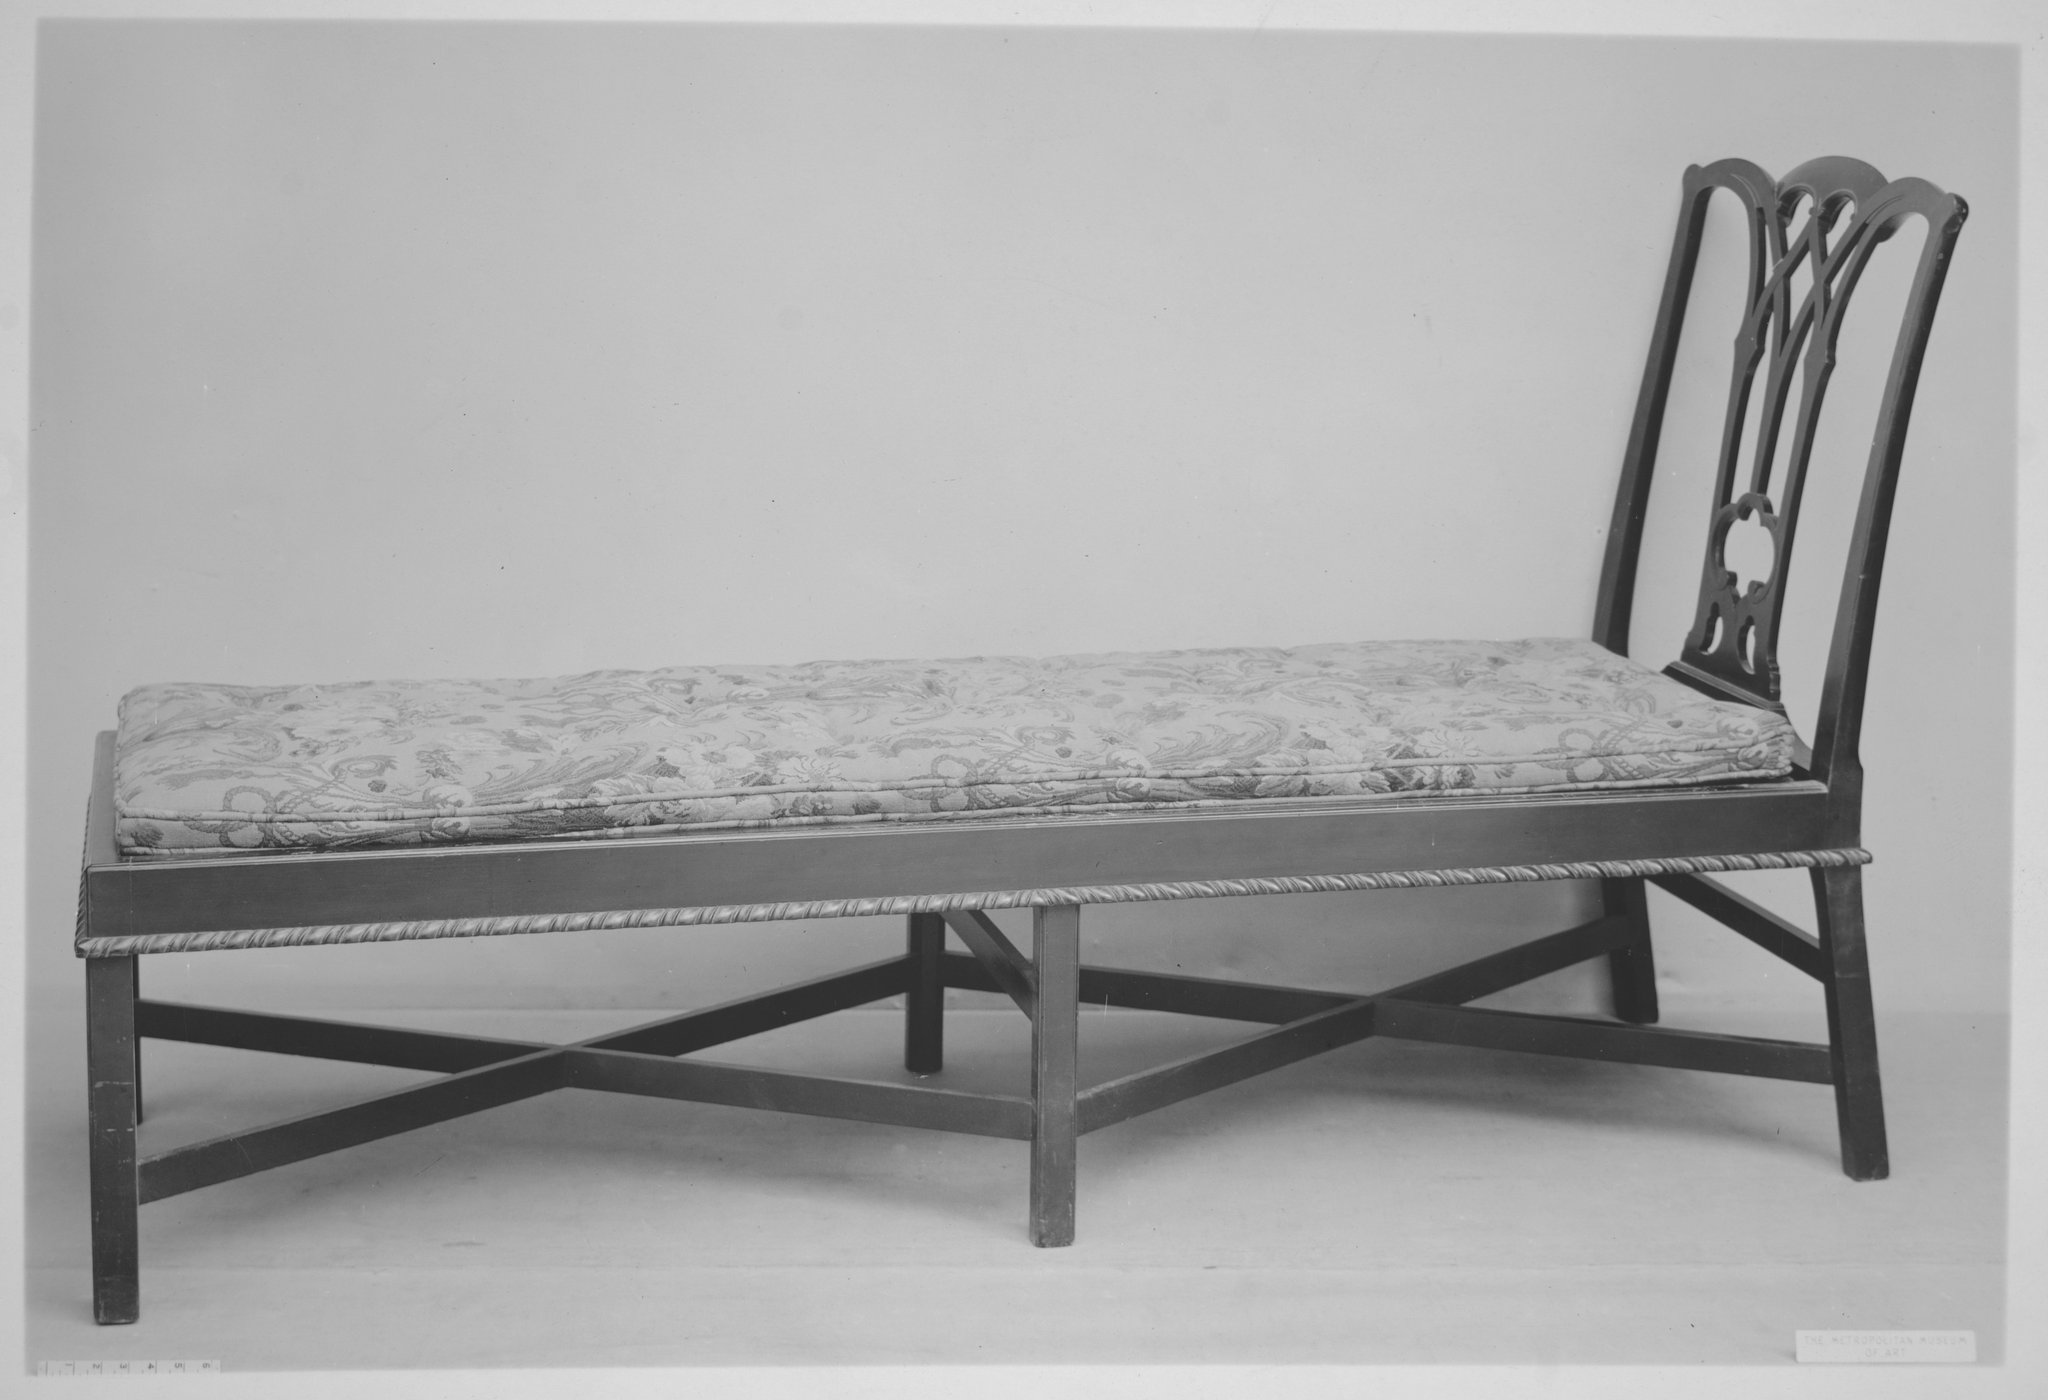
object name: daybed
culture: american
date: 1760-1790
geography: united states